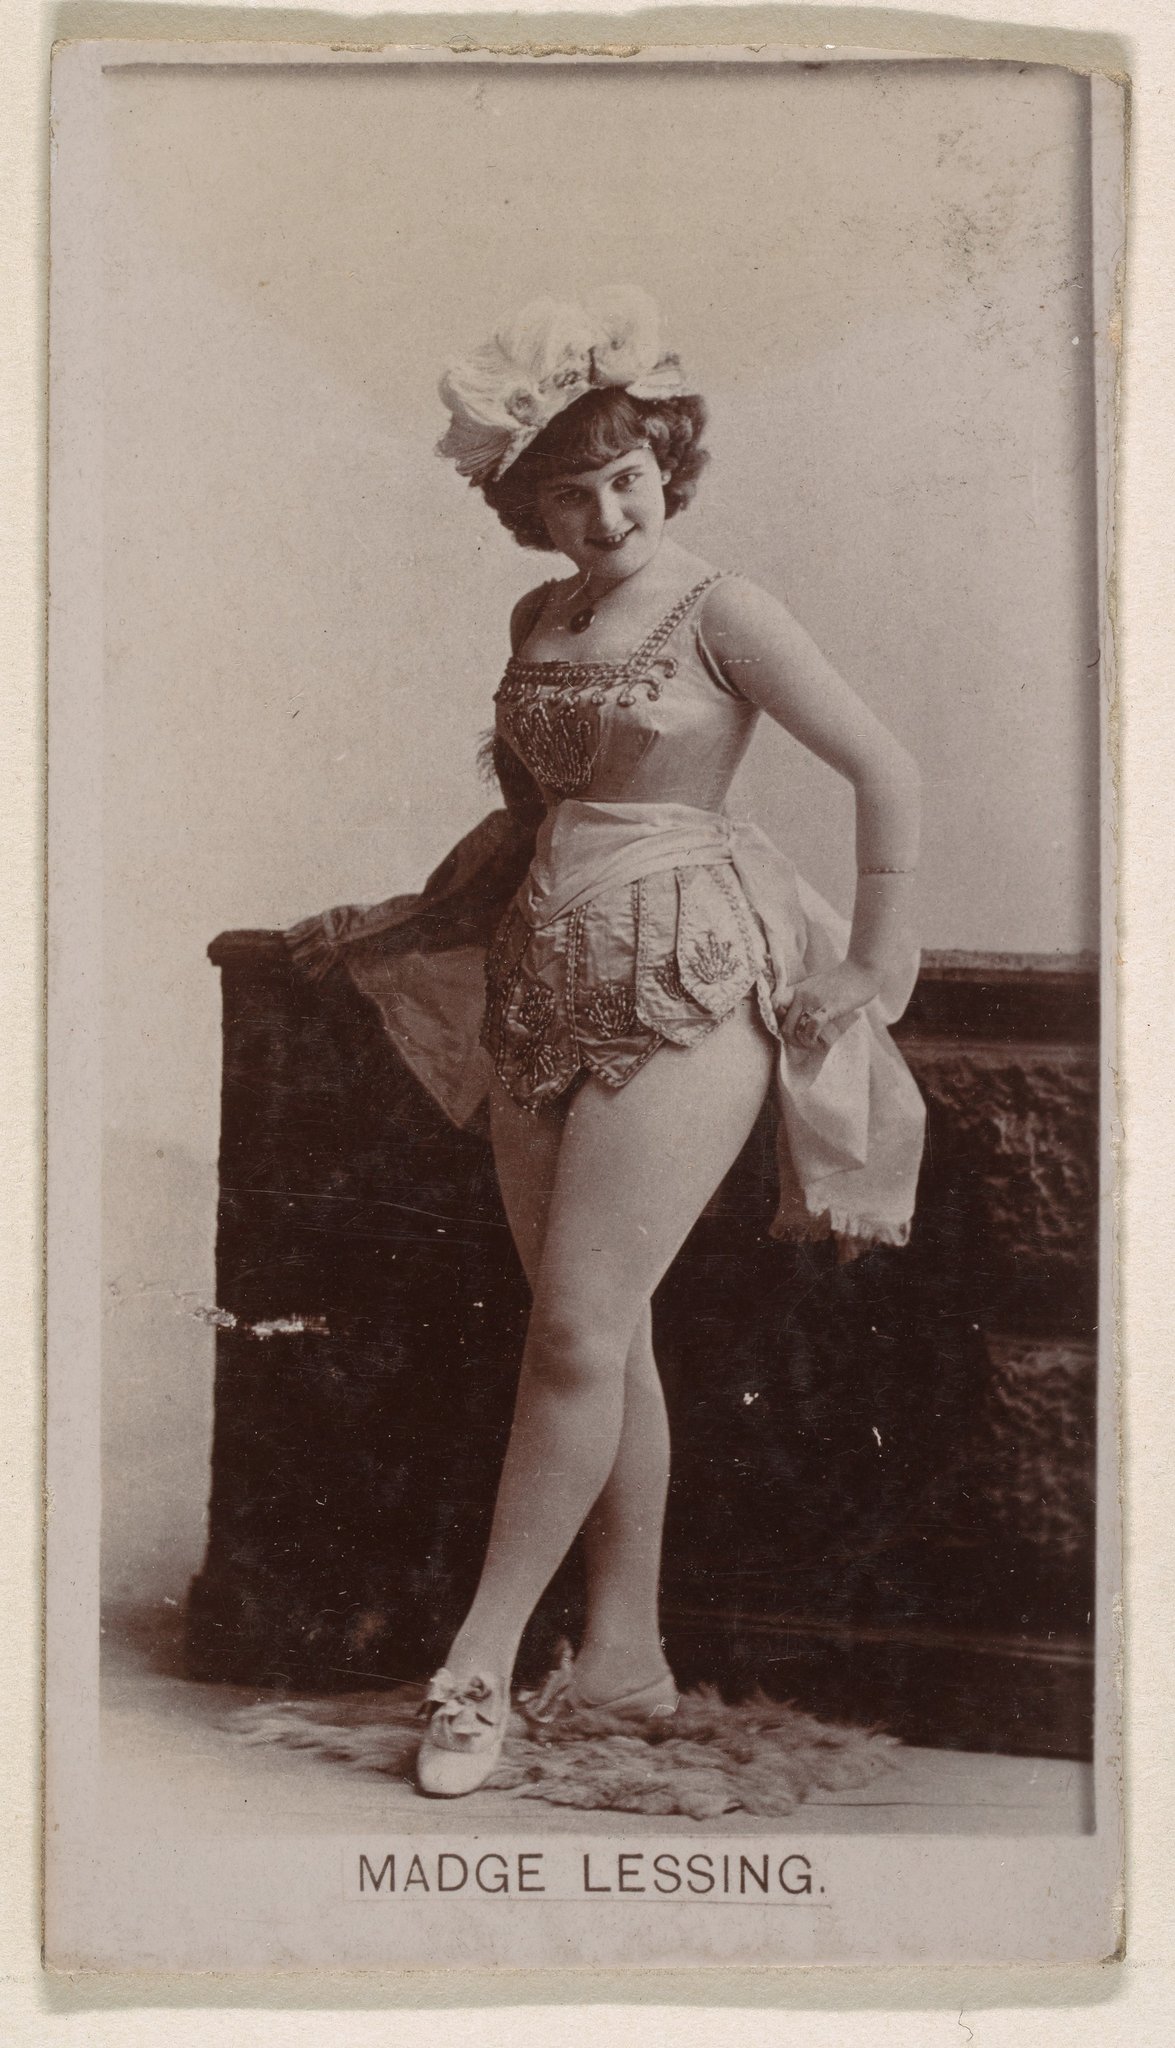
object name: photograph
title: Madge Lessing, from the Actresses series (N245) issued by Kinney Brothers to promote Sweet Caporal Cigarettes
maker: kinney brothers tobacco company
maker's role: publisher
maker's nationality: american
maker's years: 1869-2011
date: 1890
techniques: albumen silver print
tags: portraits,women,actresses